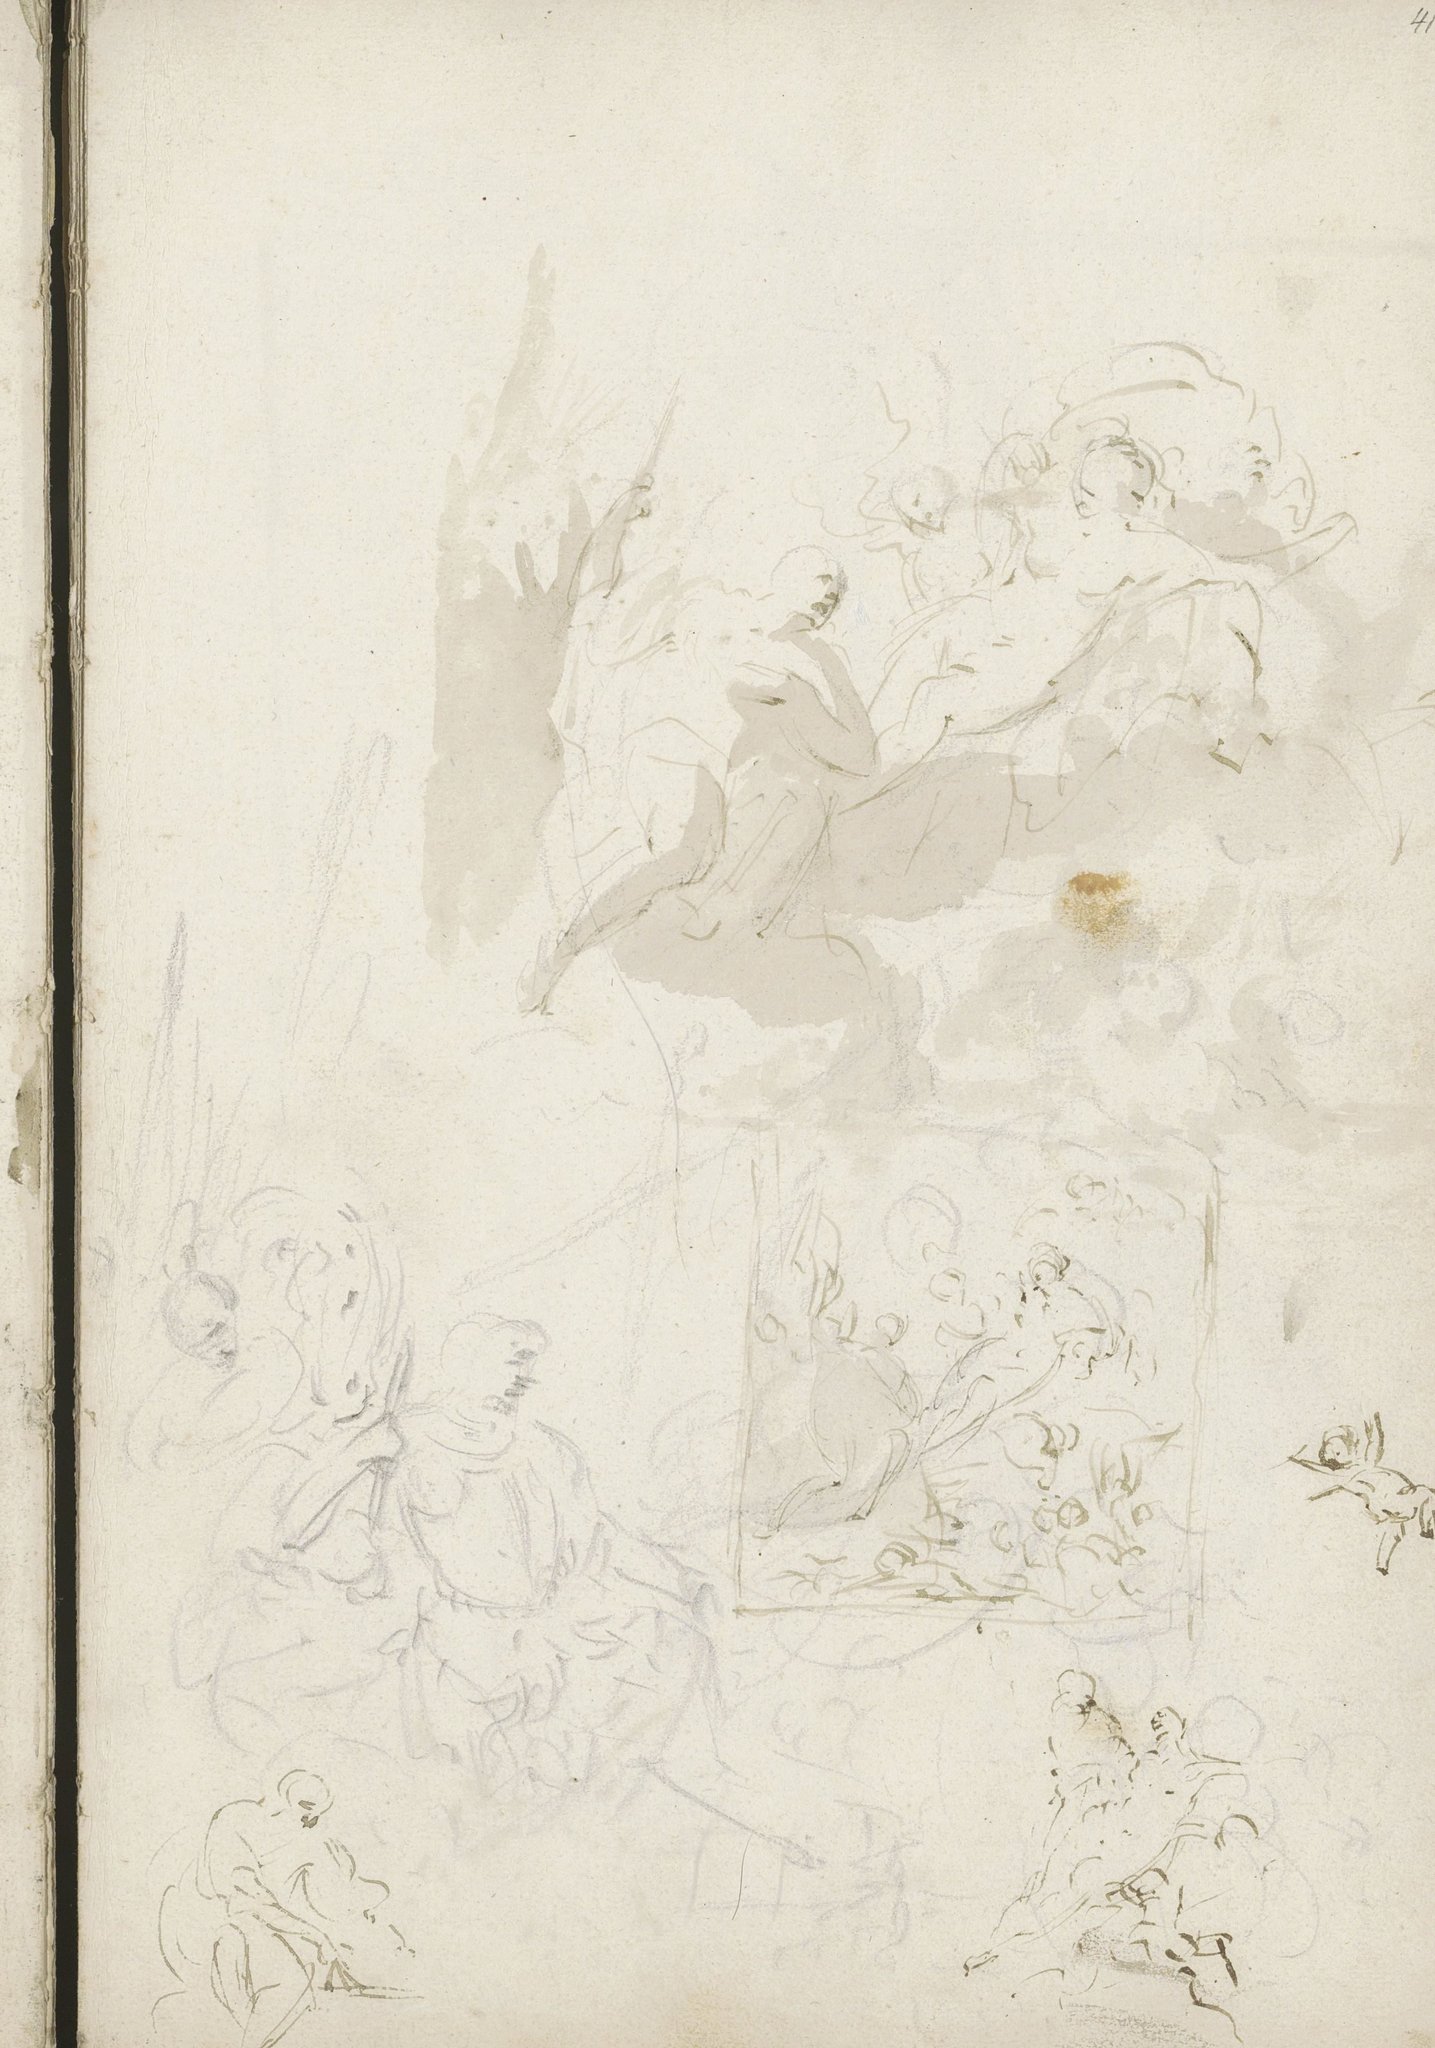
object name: sketchbook leaf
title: Compositiestudies, een putto en figuren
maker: Anonymous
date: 1650-1799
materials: ink, paper, pencil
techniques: brush, pen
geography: italy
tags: anatomy (non-medical), cupids: 'amores', 'amoretti', 'putti'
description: Bladzijde 41 uit een schetsboek met 72 bladzijden.